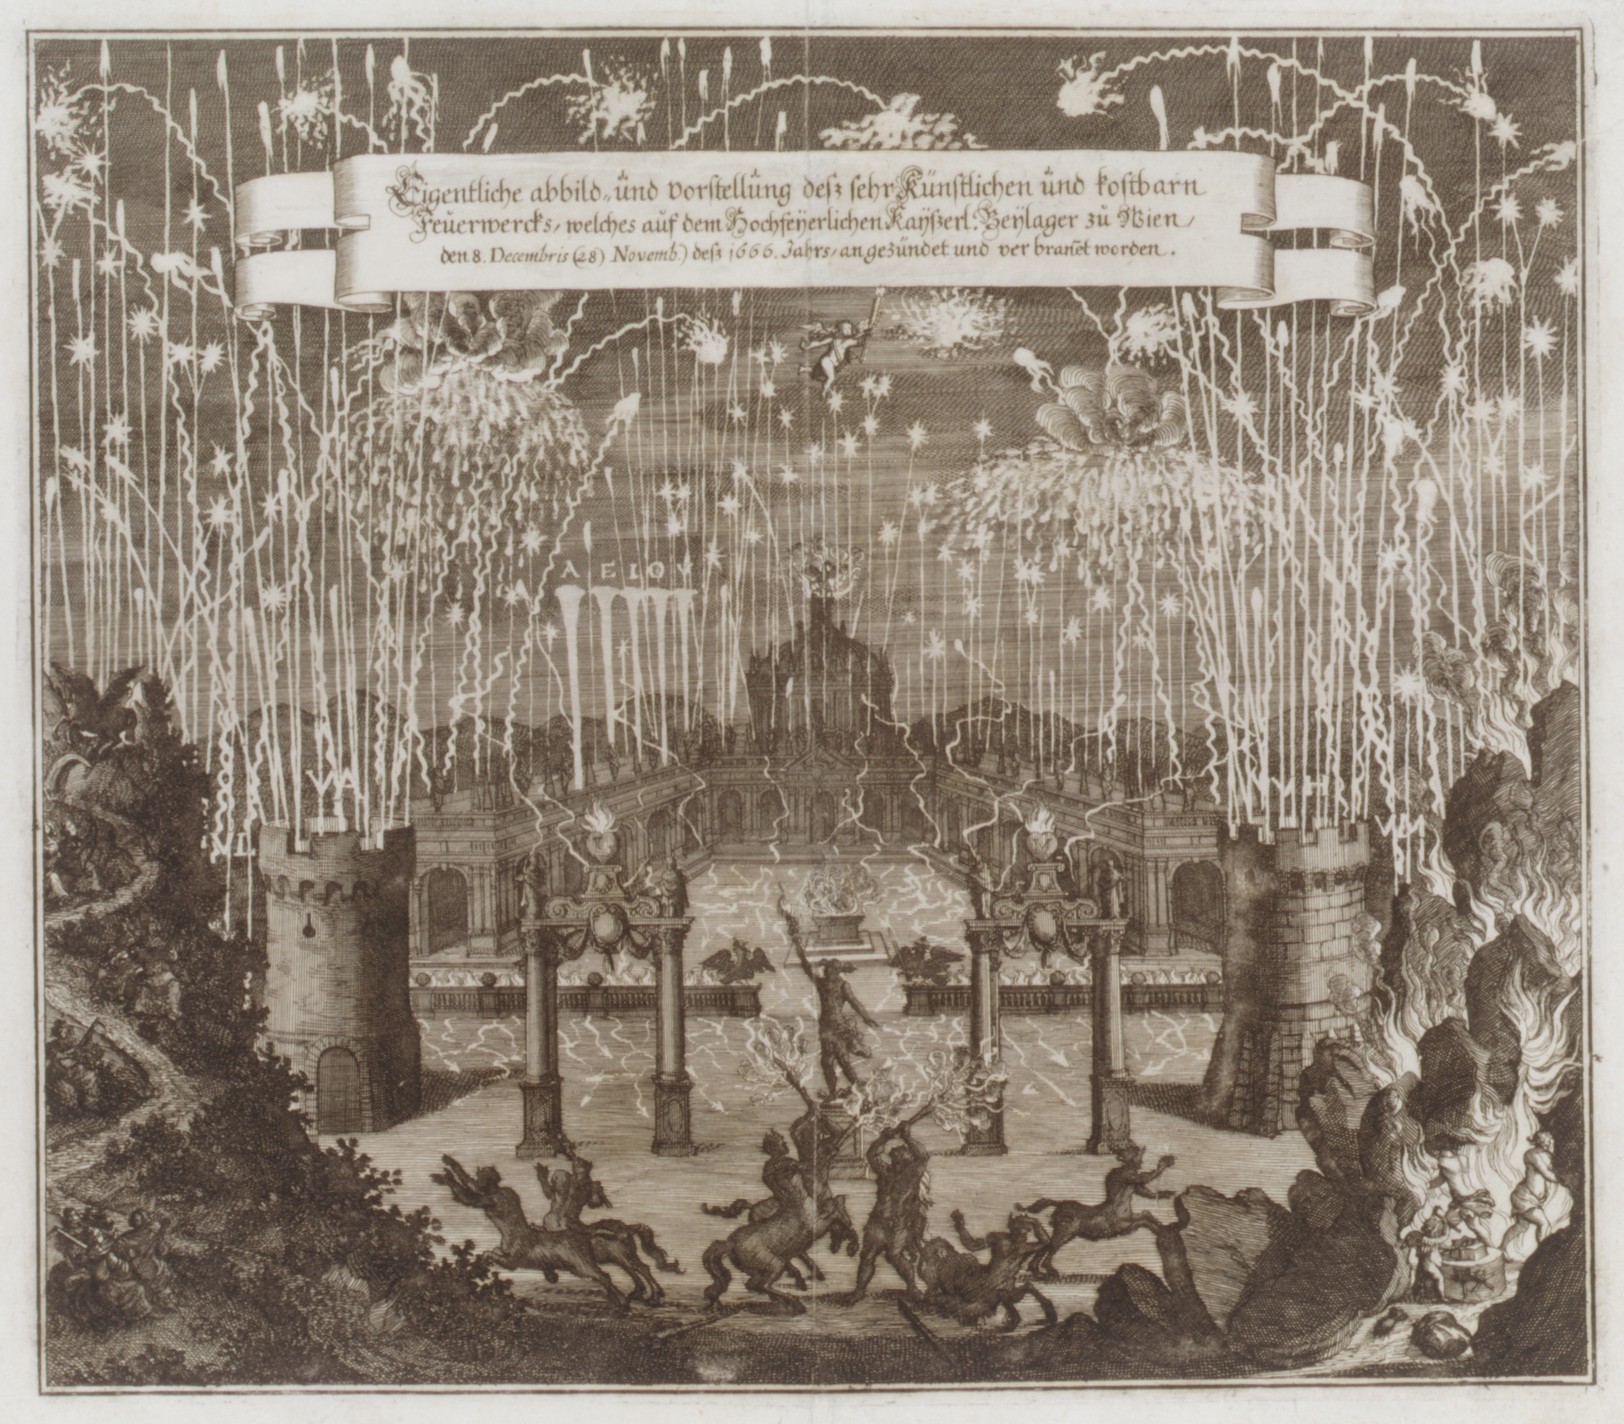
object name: print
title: Birth and Christening of Frederick, Duke of Württemberg, Stuttgart, March 17, 1616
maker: matthäus merian the elder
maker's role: artist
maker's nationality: swiss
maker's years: 1593-1650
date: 1601-1700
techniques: etching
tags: gardens,fireworks